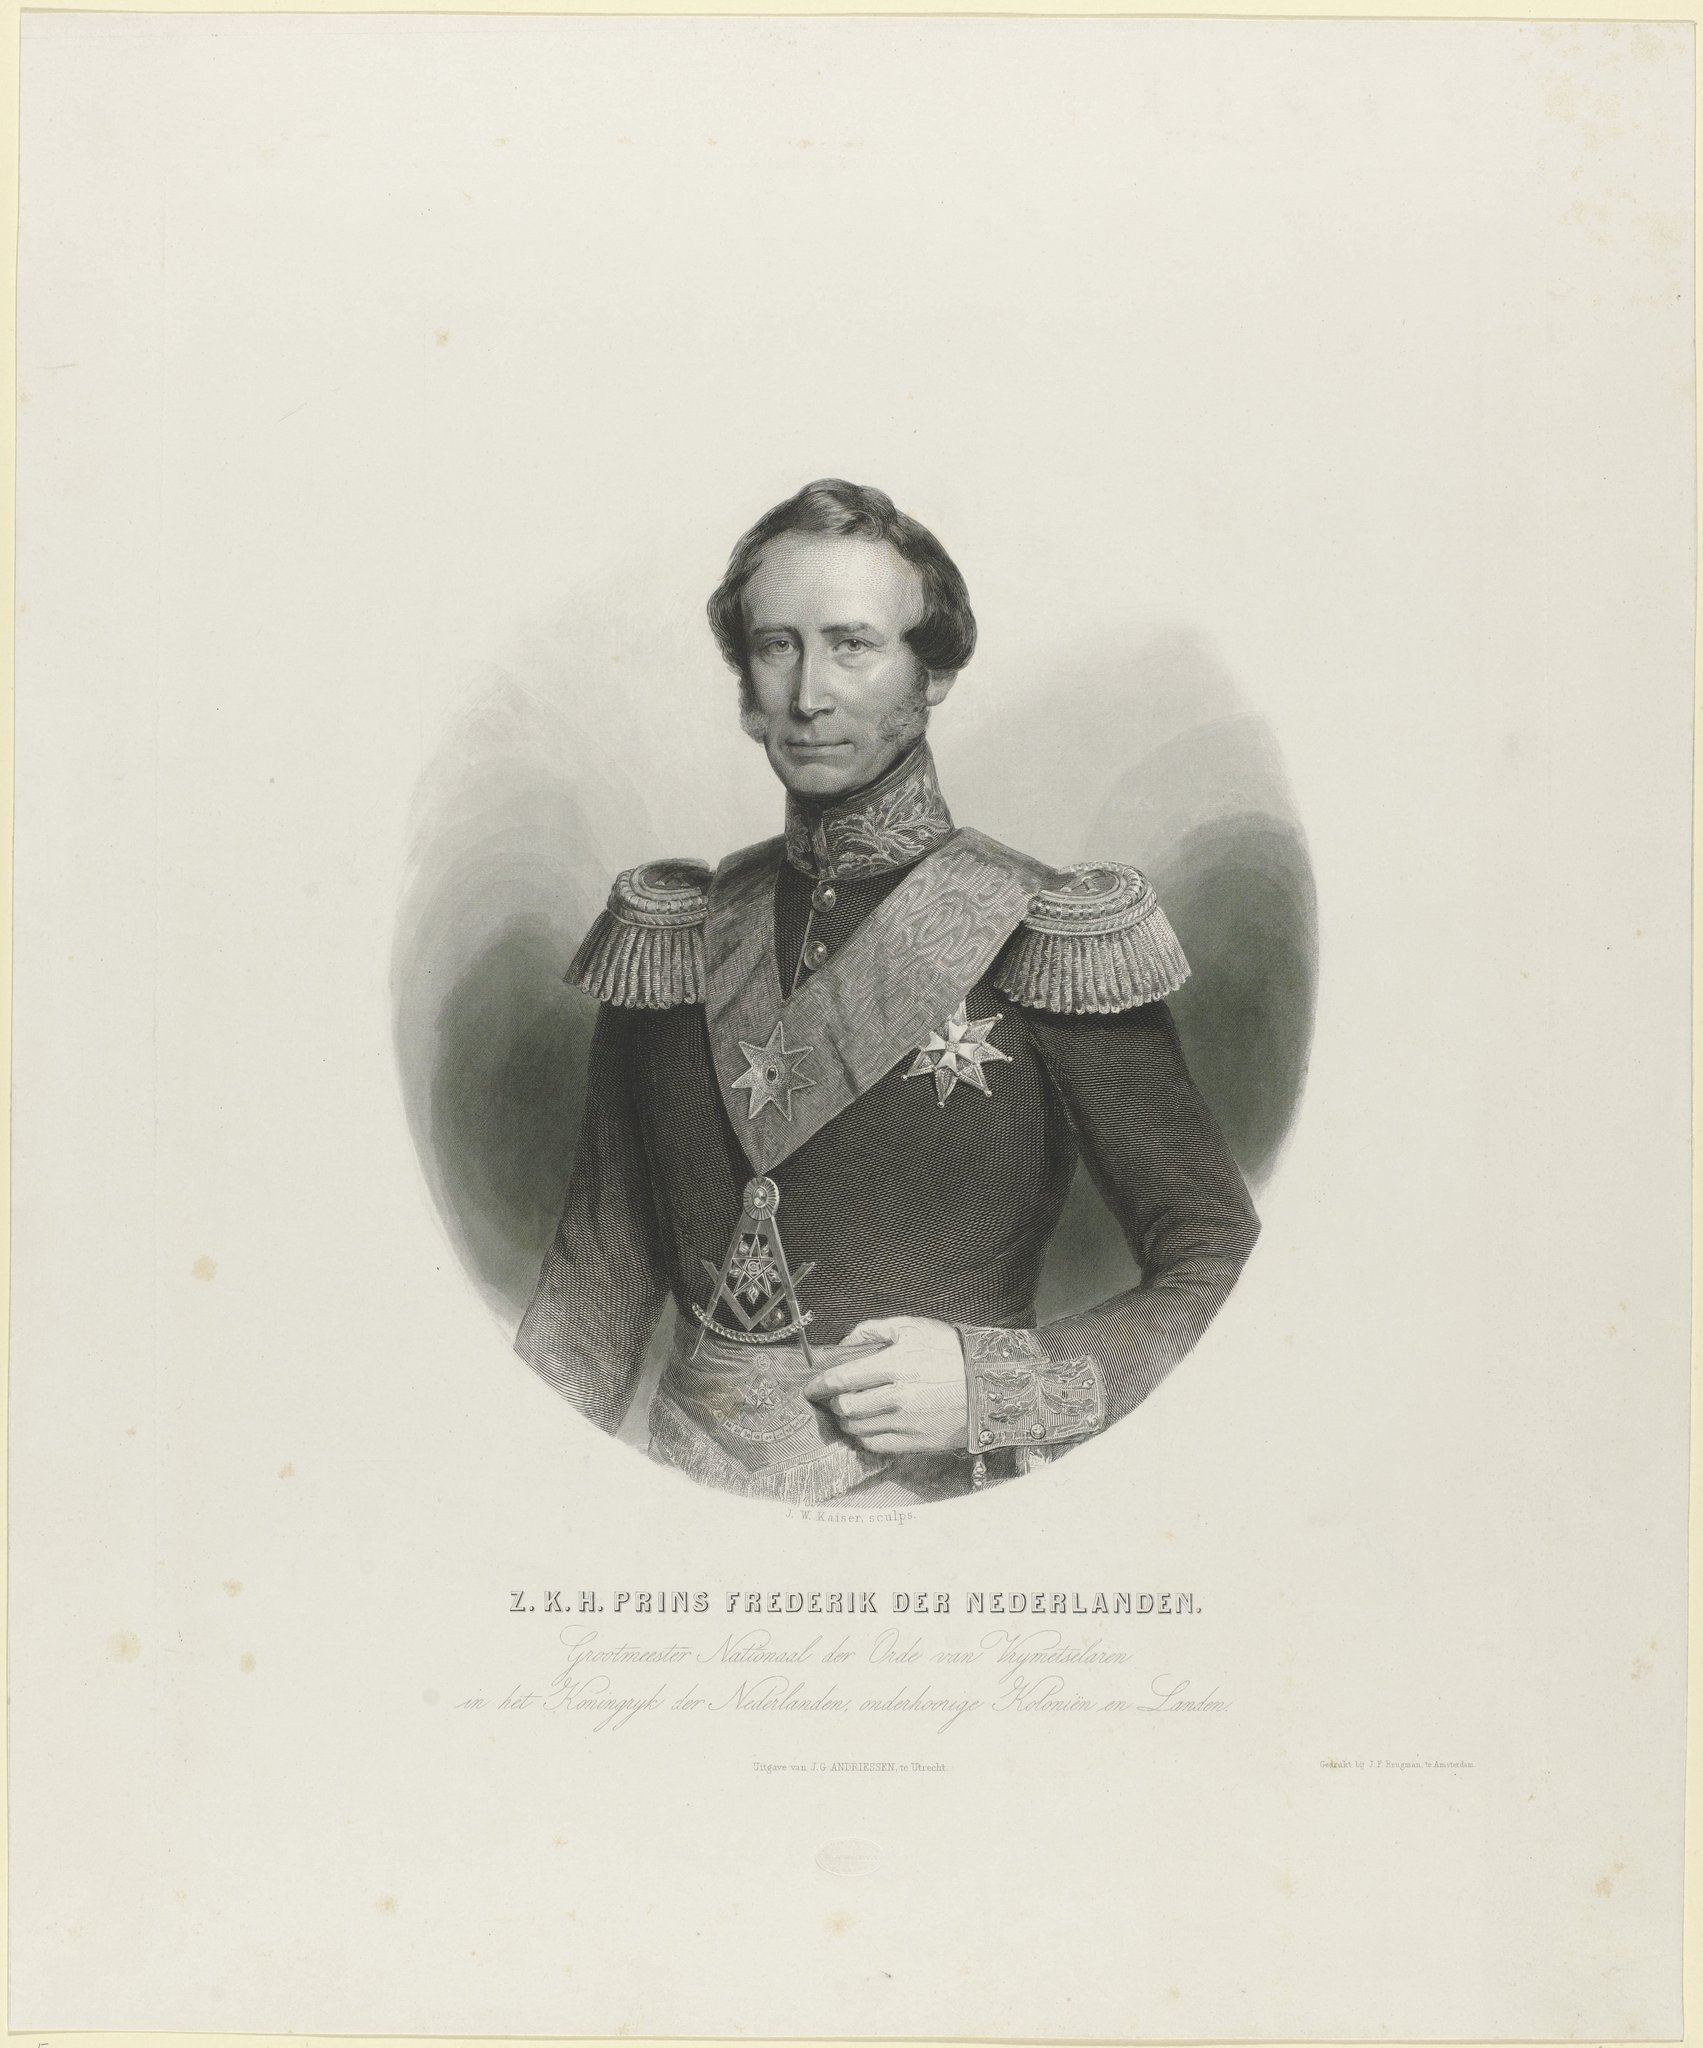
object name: print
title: Portret van Frederik, prins der Nederlanden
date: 1816-1865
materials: paper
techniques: engraving, etching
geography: amsterdam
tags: berlin, frederik (prins der nederlanden)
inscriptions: check stamp: ‘J.G. Andriessen Utrecht’, collector's mark: Lugt 963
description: De hier vermelde titel verwijst naar de hoogst verkregen titel van de geportretteerde, niet per se naar de titel die de geportretteerde op deze voorstelling draagt.